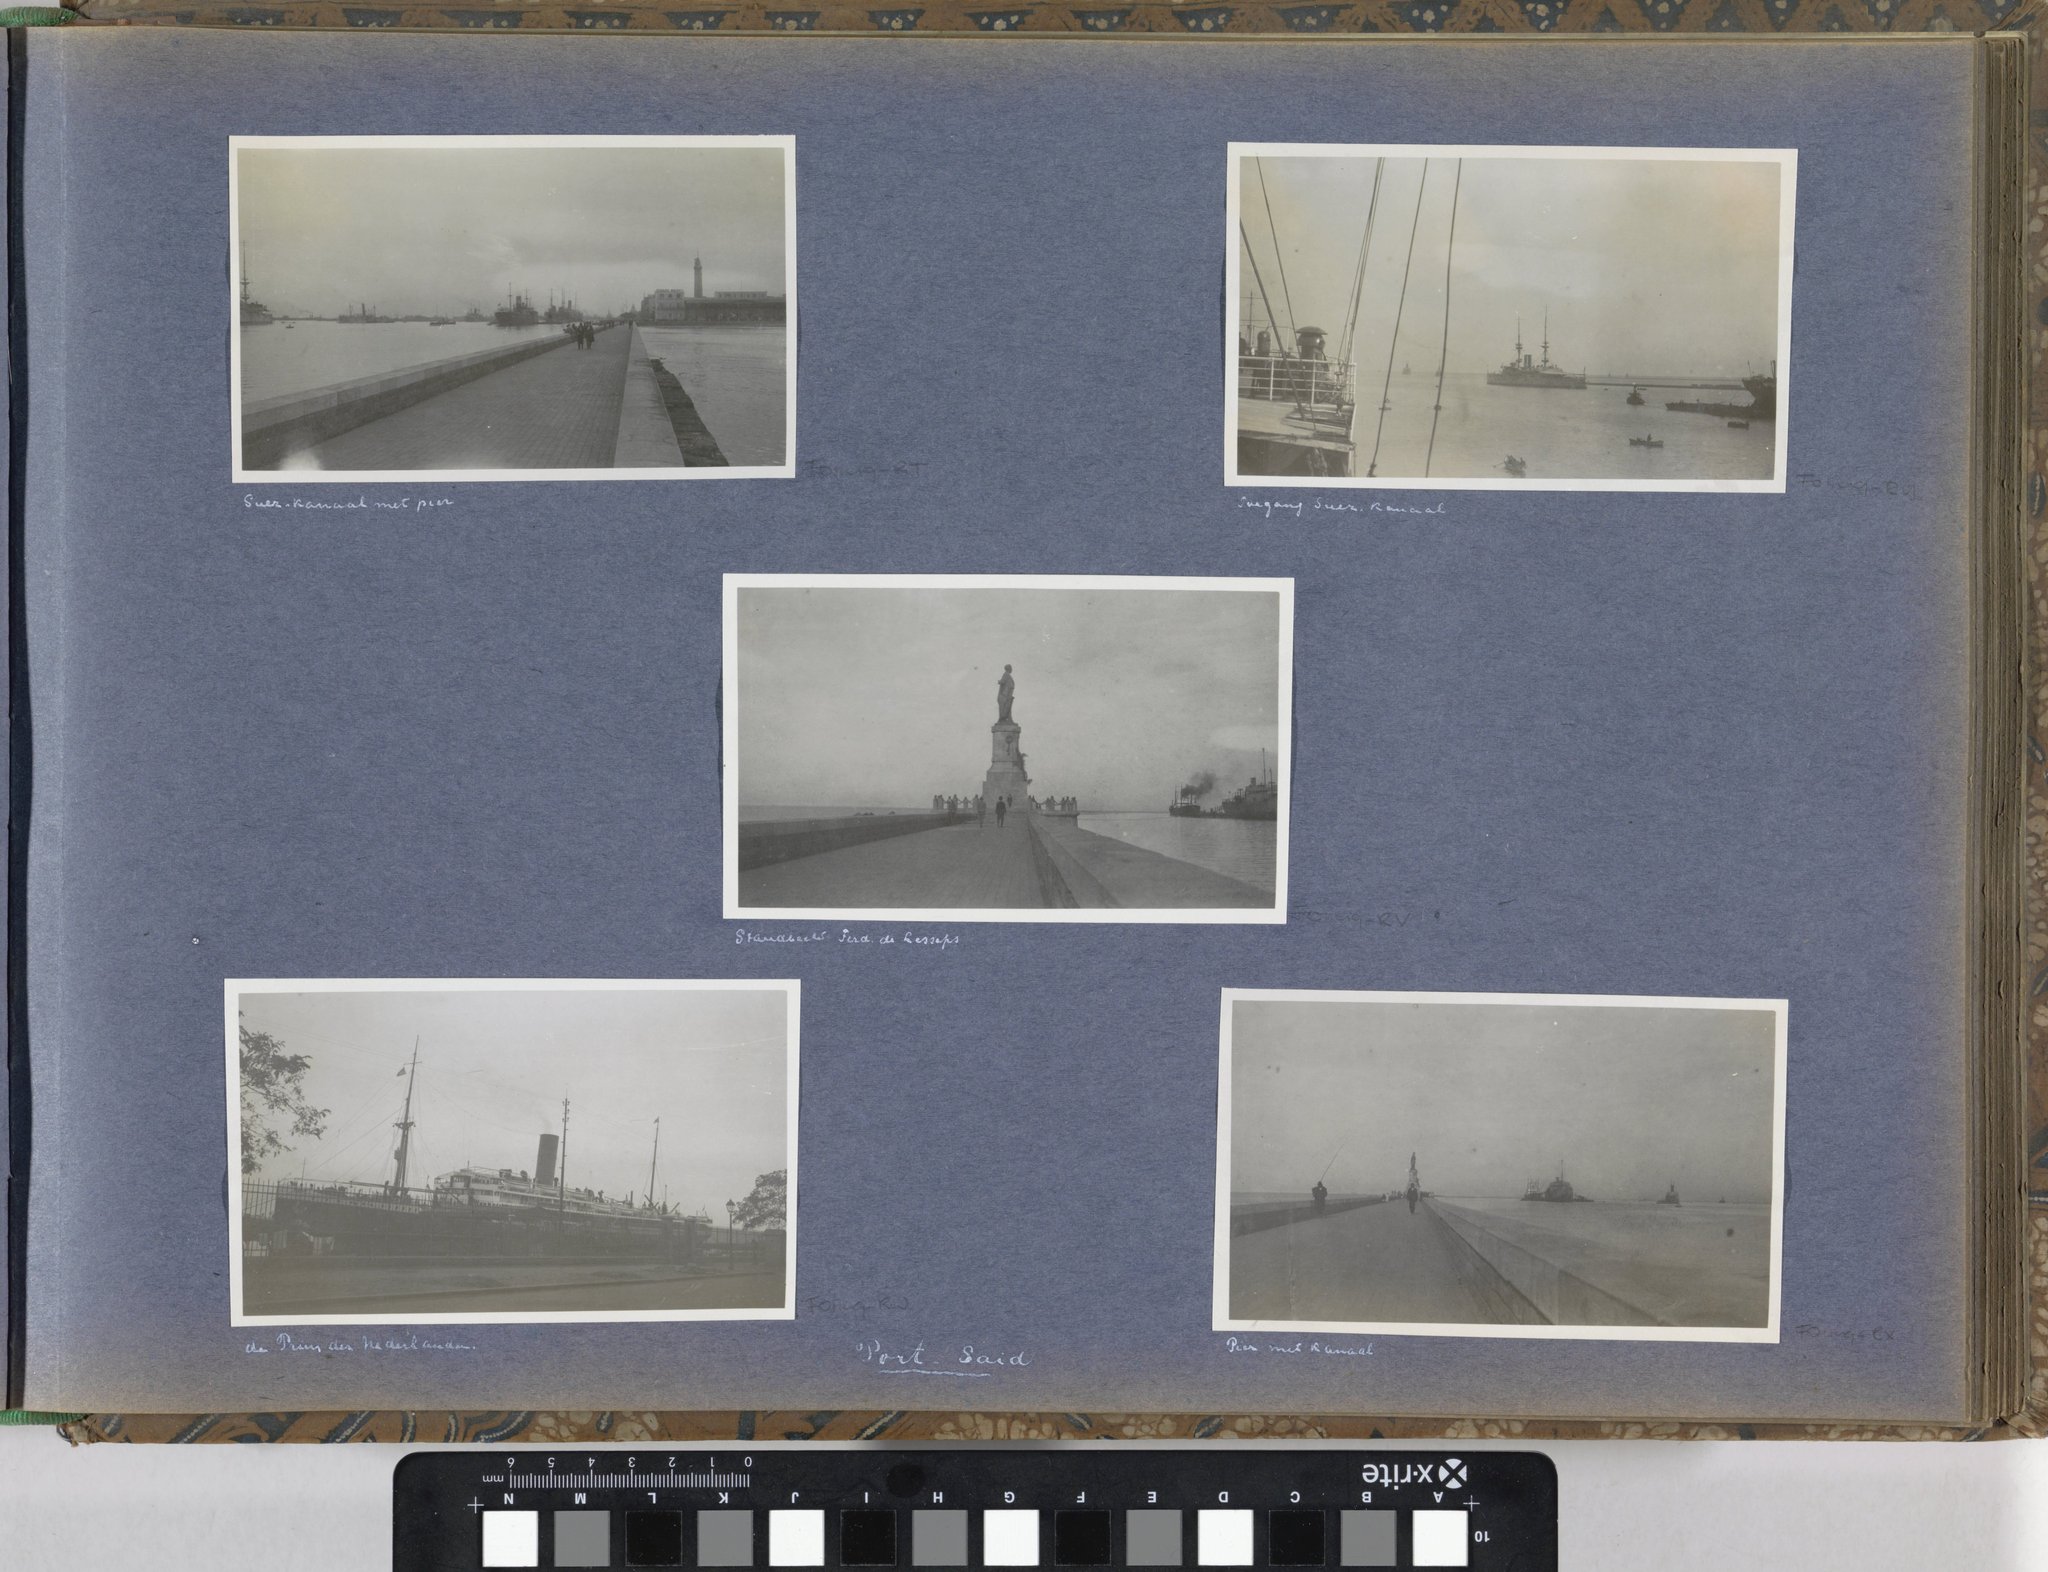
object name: album leaf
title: Suezkanaal met pier in Port Said met op de achtergrond reclame voor 'Dewar's whisky'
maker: Anonymous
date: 1900-1920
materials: paper, photographic support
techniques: gelatin silver print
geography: port said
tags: advertising, canal, pier, quay, wharf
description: Onderdeel van reisalbum met foto's van bedrijvigheid en bezienswaardigheden op Sumatra en Java en van de reis naar en van Nederlands-Indië.